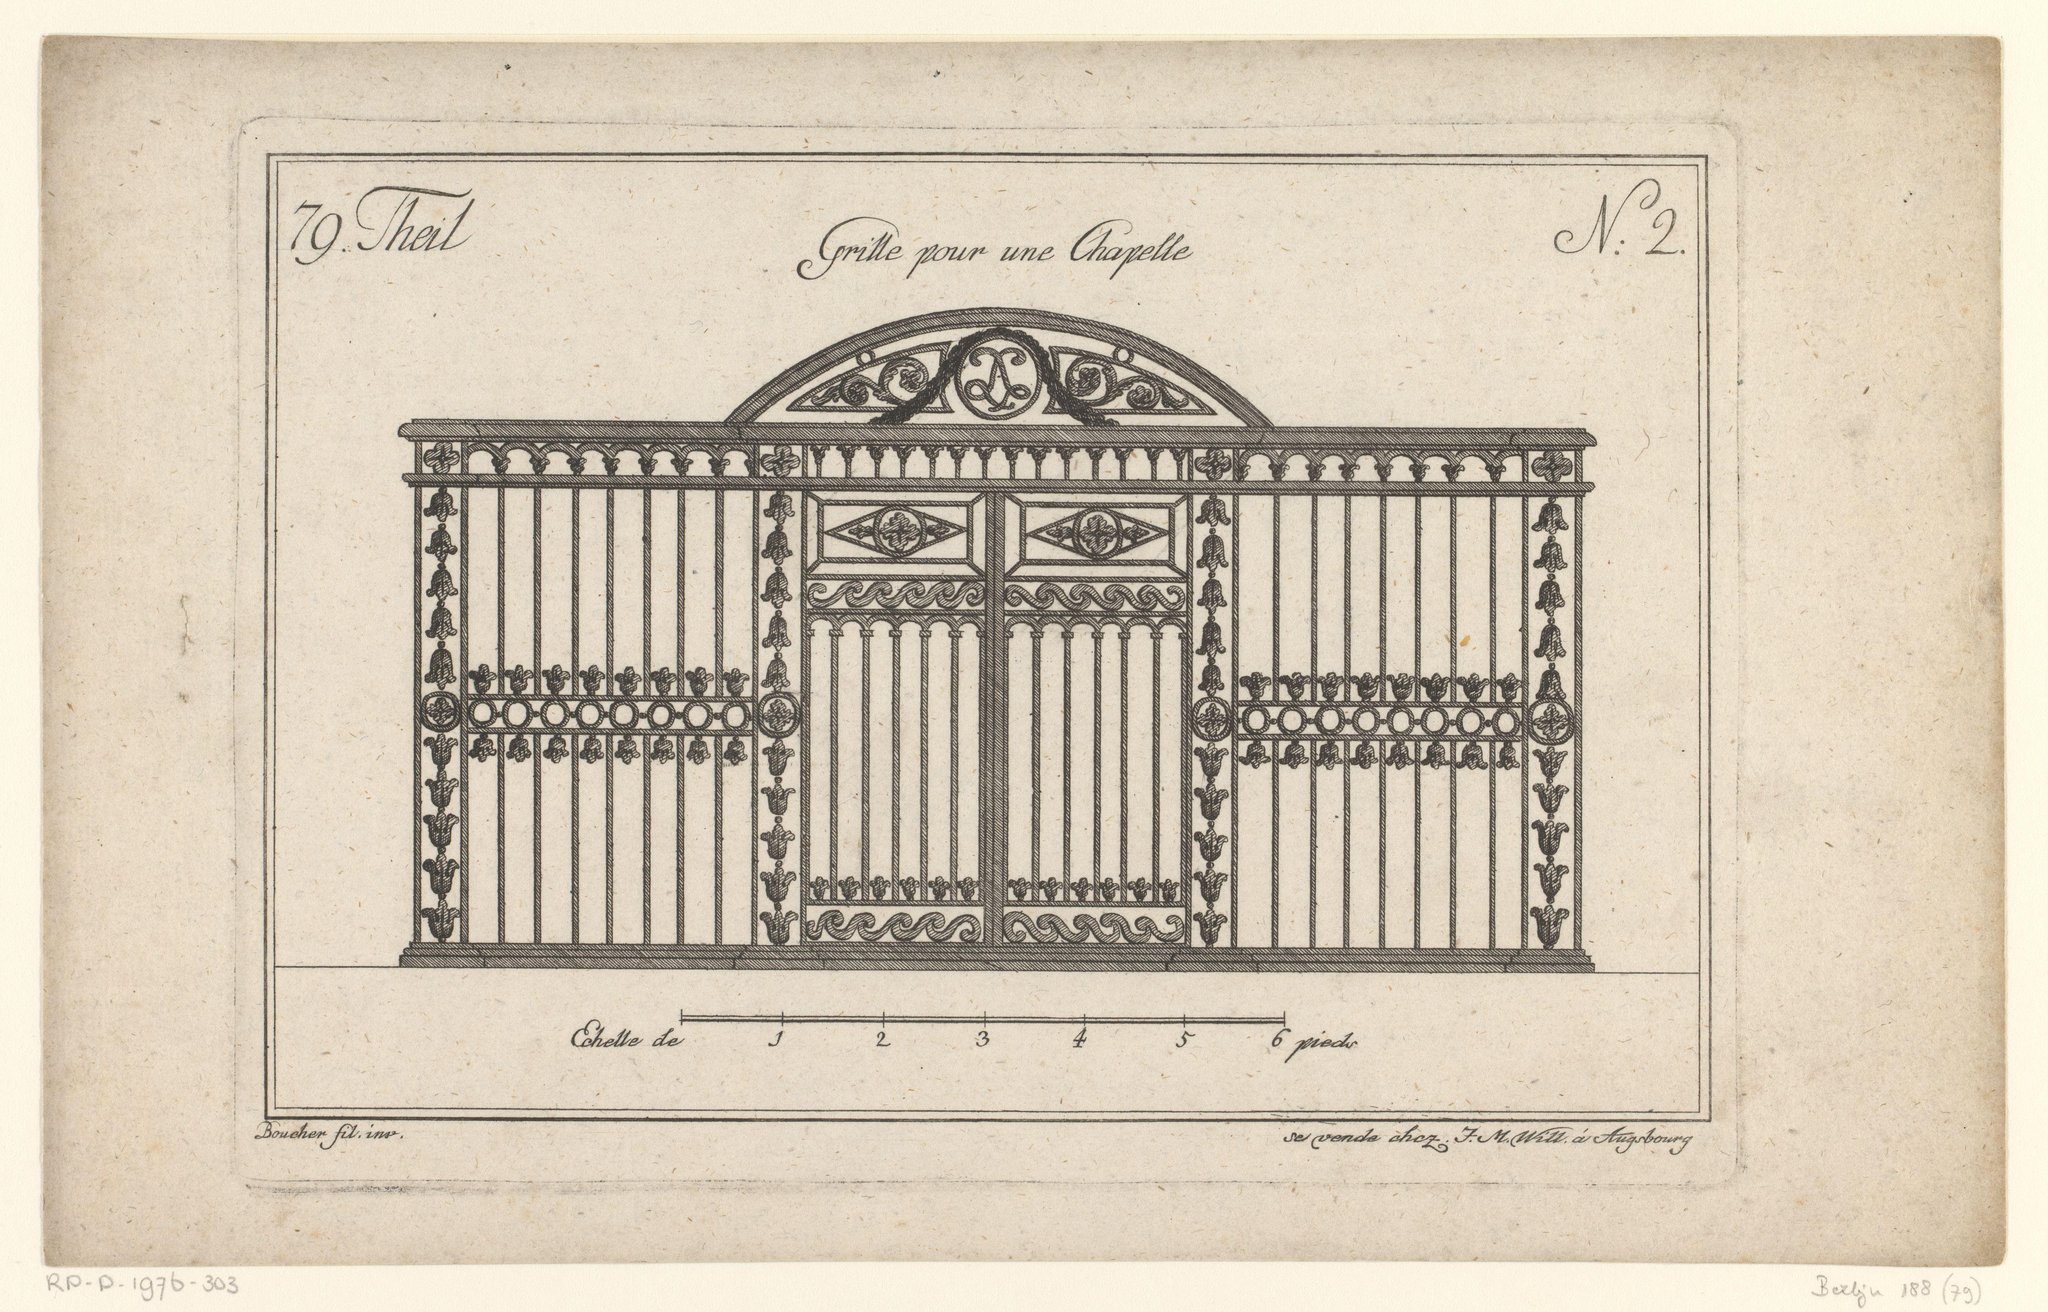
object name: ornament print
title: Hekwerk voor een kapel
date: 1746-1782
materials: paper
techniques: etching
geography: augsburg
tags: welding (industrial process), fence, wall, paling, parts of church interior: chapel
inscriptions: collector's mark: Lugt 2228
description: Een smeedijzeren hekwerk met bloemmotieven.